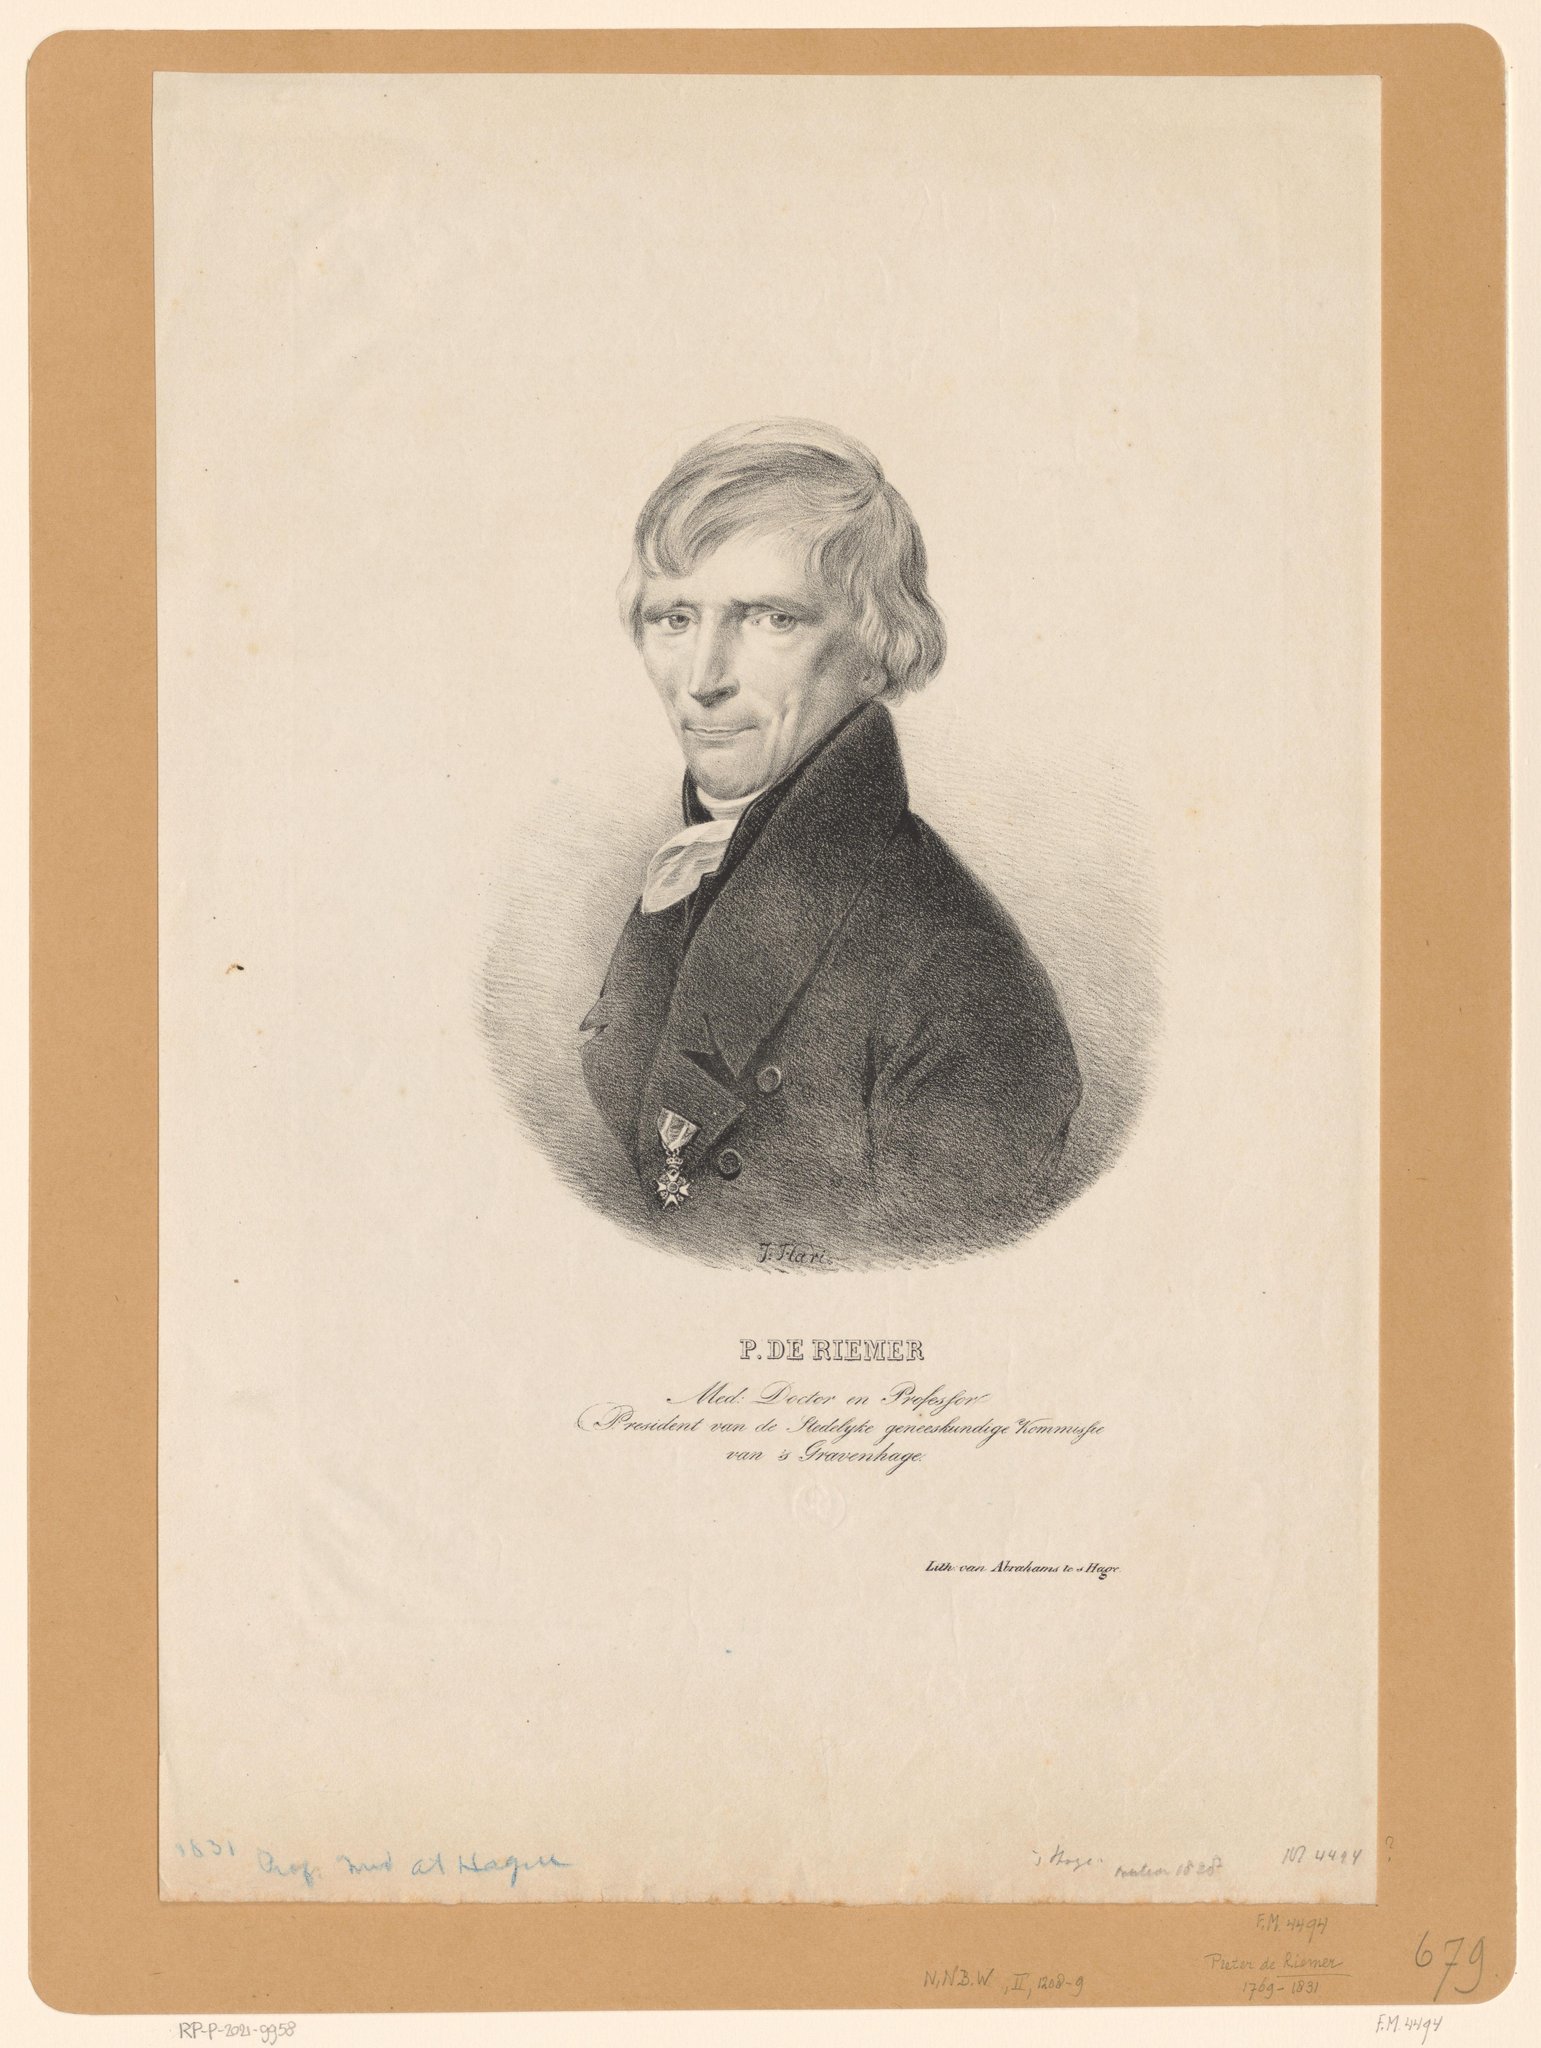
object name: print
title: Portret van Pieter de Riemer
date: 1823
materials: paper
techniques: lithograph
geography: the hague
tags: knighthood order, historical persons, physician, doctor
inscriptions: check stamp